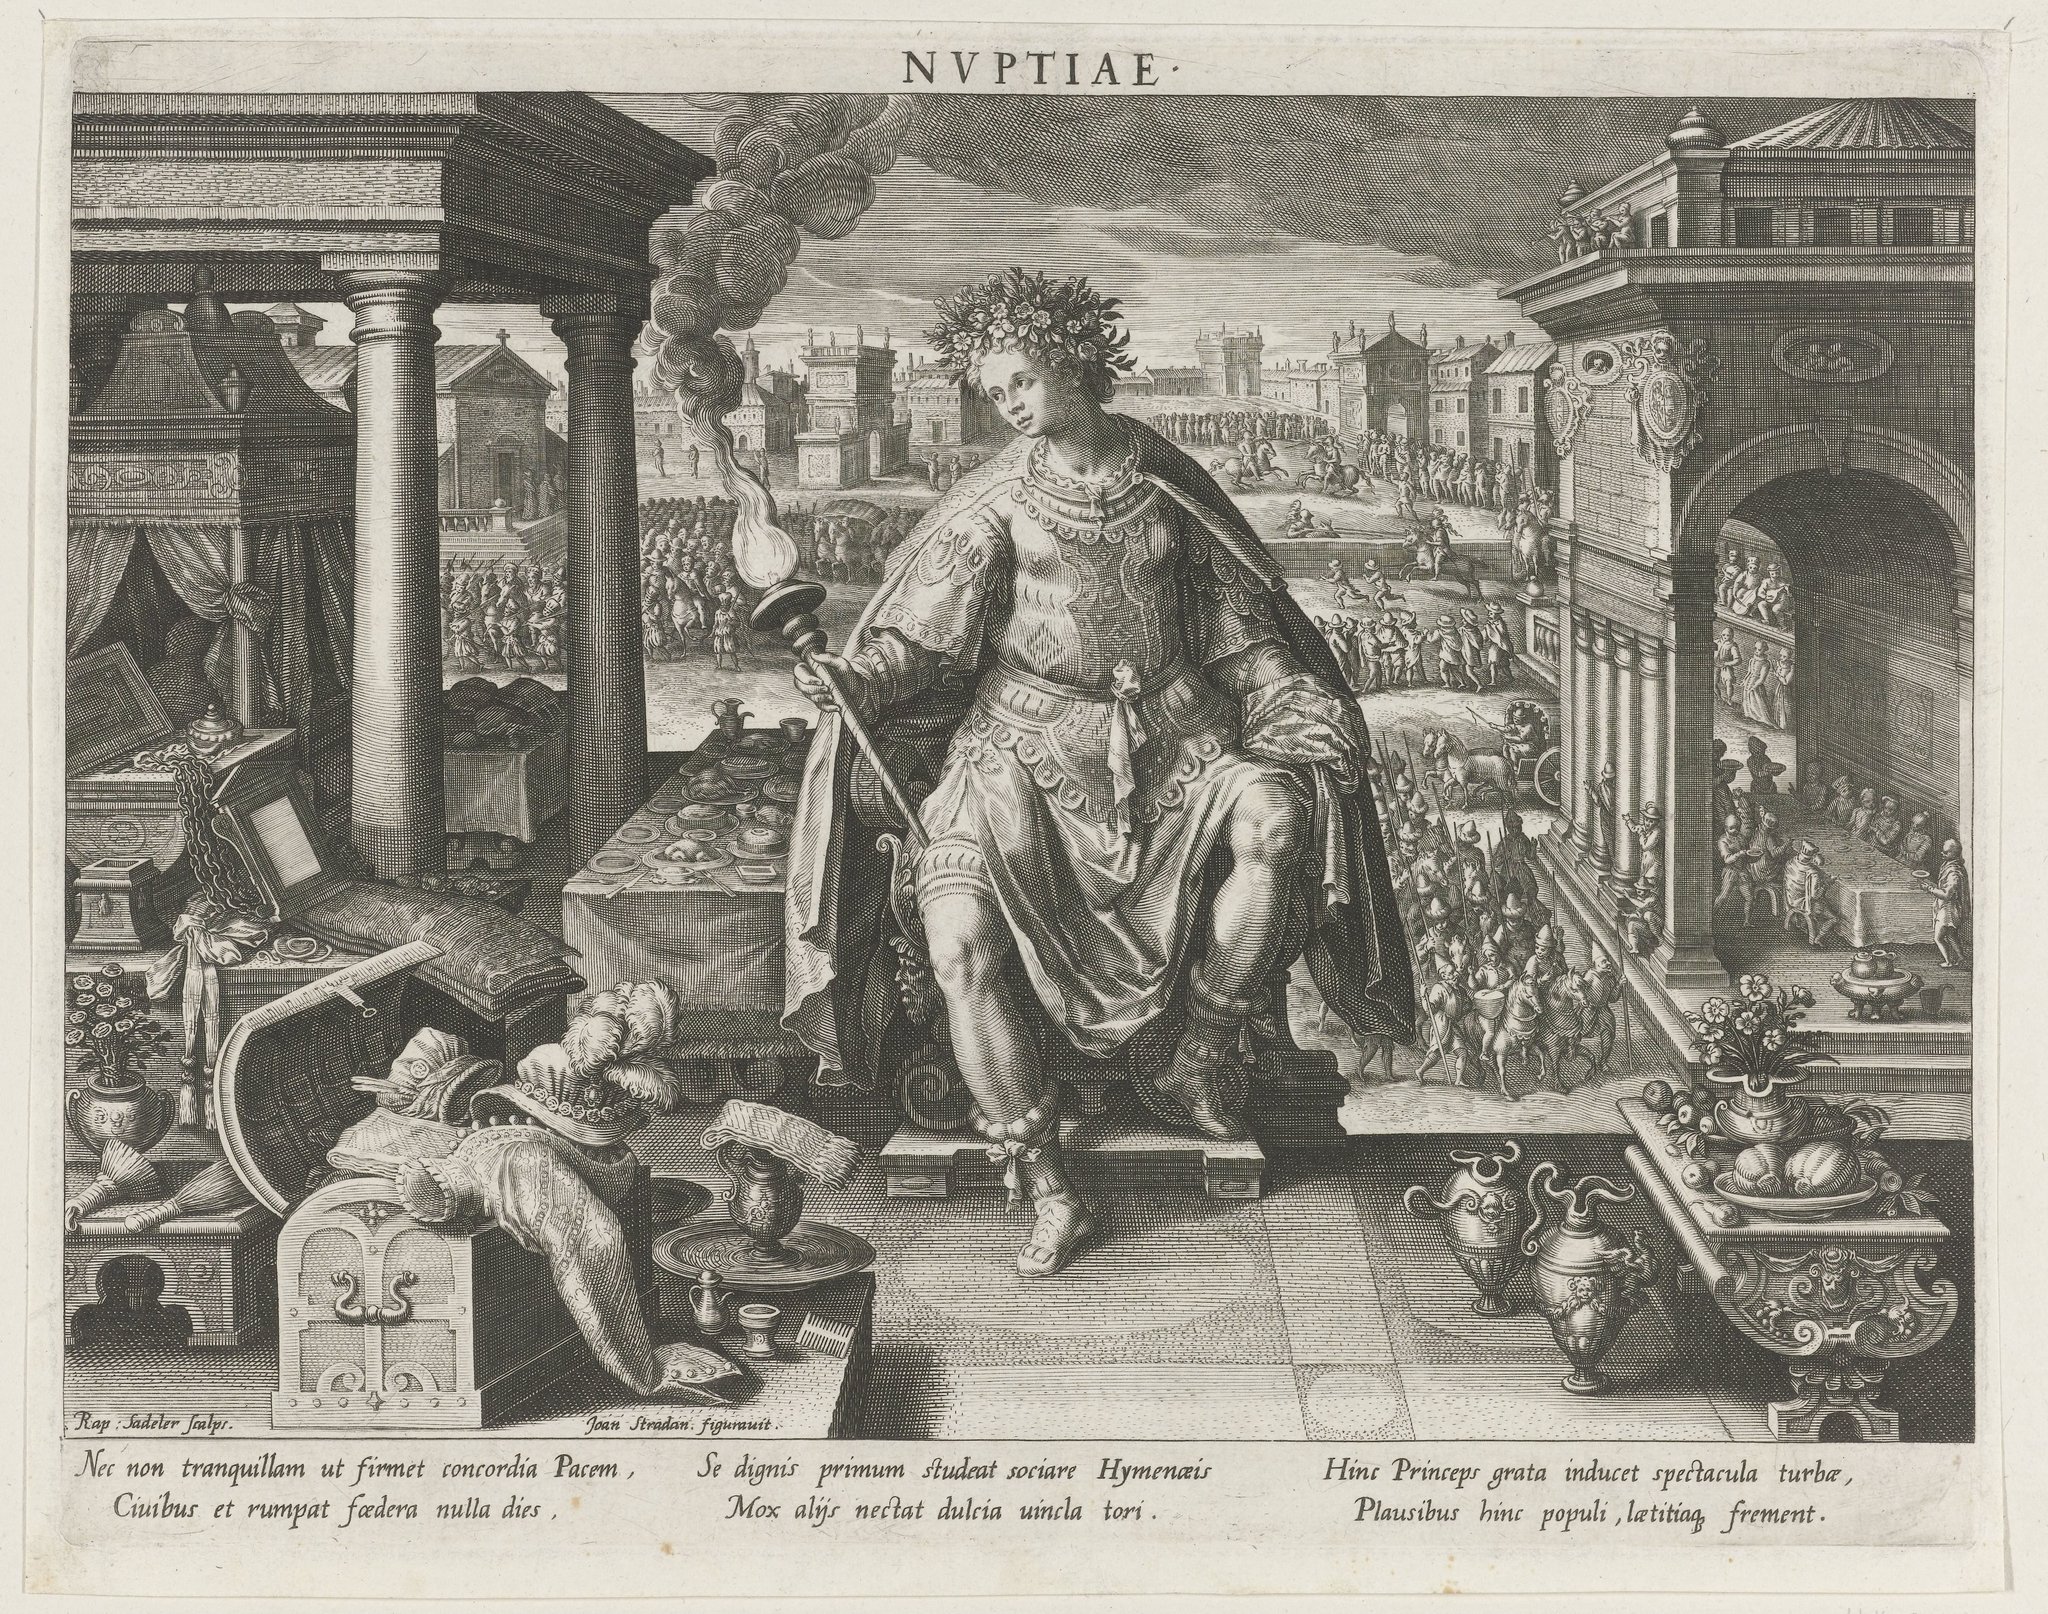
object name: print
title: Belangrijkste bezigheden van een prins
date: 1597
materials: paper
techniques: engraving, etching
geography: florence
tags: wedding feast, wedding meal, going to church, marriage, married couple, 'matrimonium', joust, tilt, wedding-gift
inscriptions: collector's mark: Lugt 240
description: Op de voorgrond de personificatie van het huwelijk met een fakkel in de hand. Hij wordt omringd door allerlei huwelijksgeschenken en attributen van het huwelijk (zoals het huwelijksbed en de huwelijkstafel). Op de achtergrond links de huwelijkskerkgang. Op de achtergrond rechts een toernooi ter ere van een bruiloft. Rechts de bruiloftsmaaltijd. De prent heeft een Latijns onderschrift met uitleg over het belang van de een huwelijk voor een vorst. De vierde prent van een vijfdelige serie met als onderwerp de belangrijkste bezigheden van een prins.